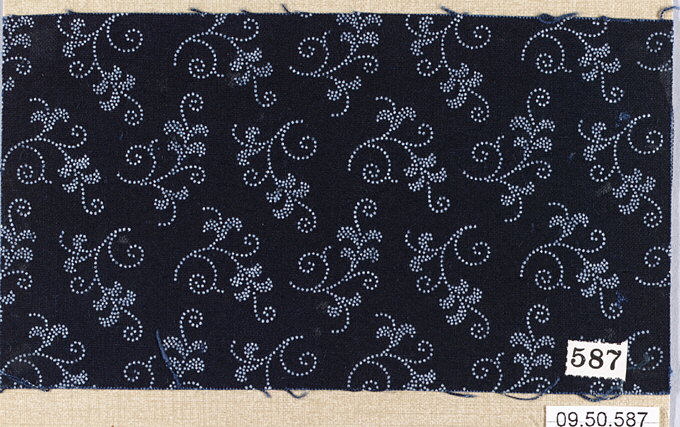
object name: piece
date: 1801-1900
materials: cotton